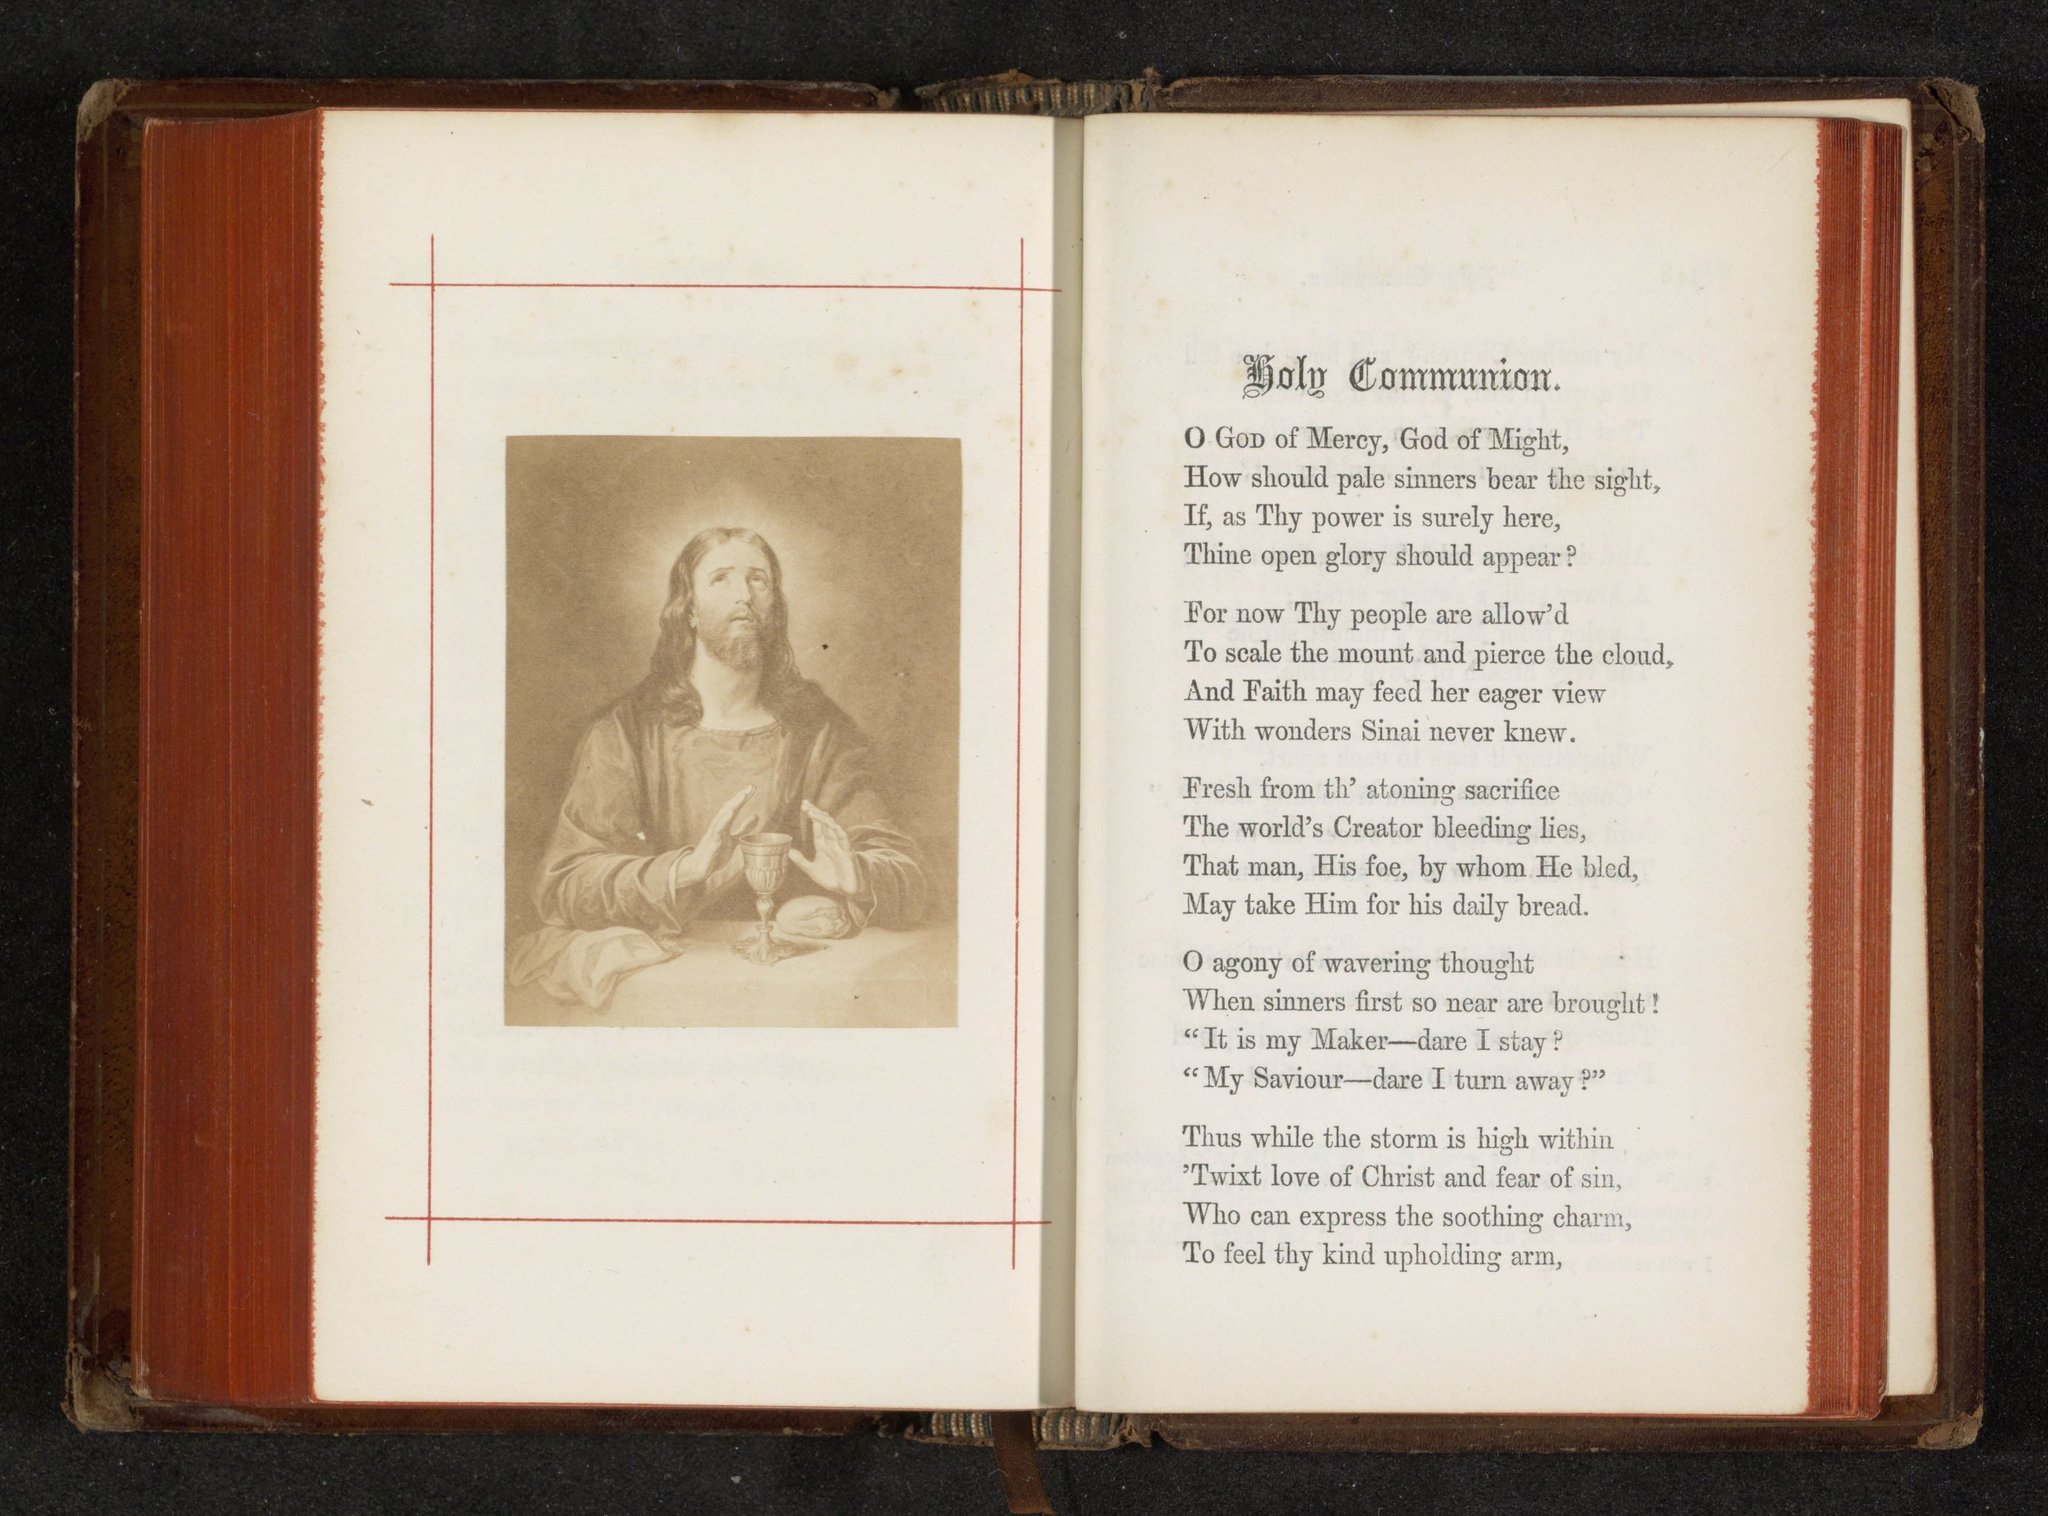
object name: photograph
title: Fotoreproductie van een prent, voorstellende Christus met brood en een kelk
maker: Anonymous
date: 1865-1870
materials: photographic support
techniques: albumen print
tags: christ with chalice, and bread or host